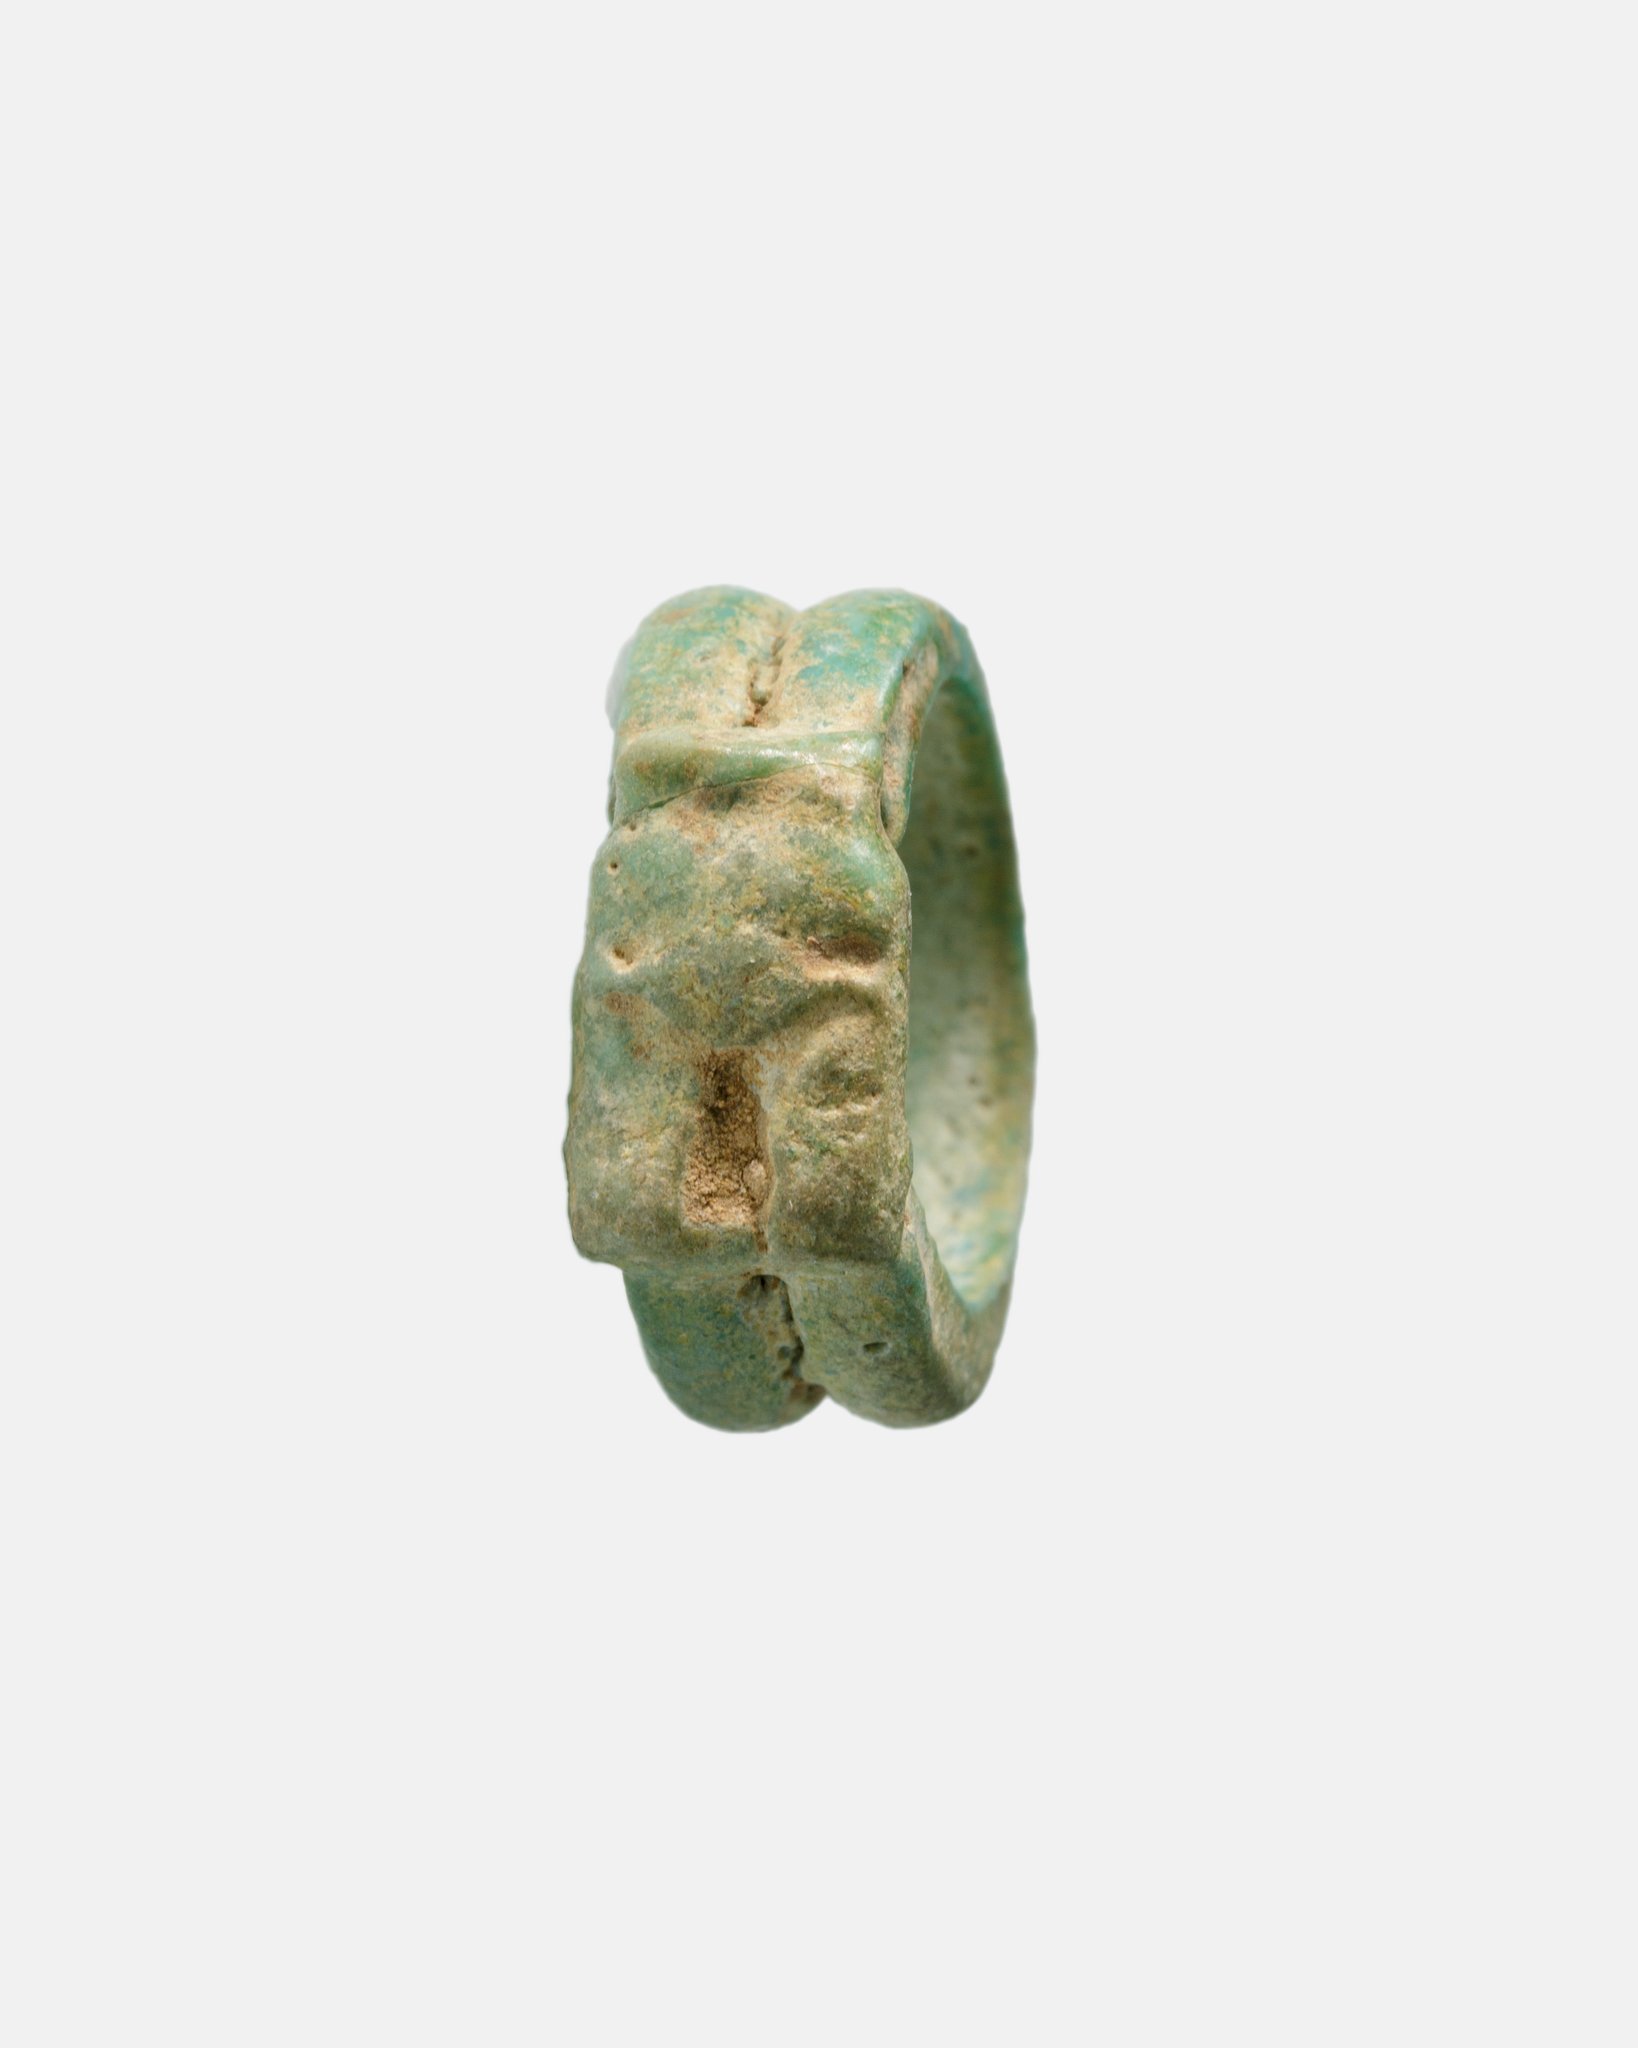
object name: ring, hathor head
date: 1184-1070 BCE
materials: faience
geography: northern upper egypt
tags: hathor